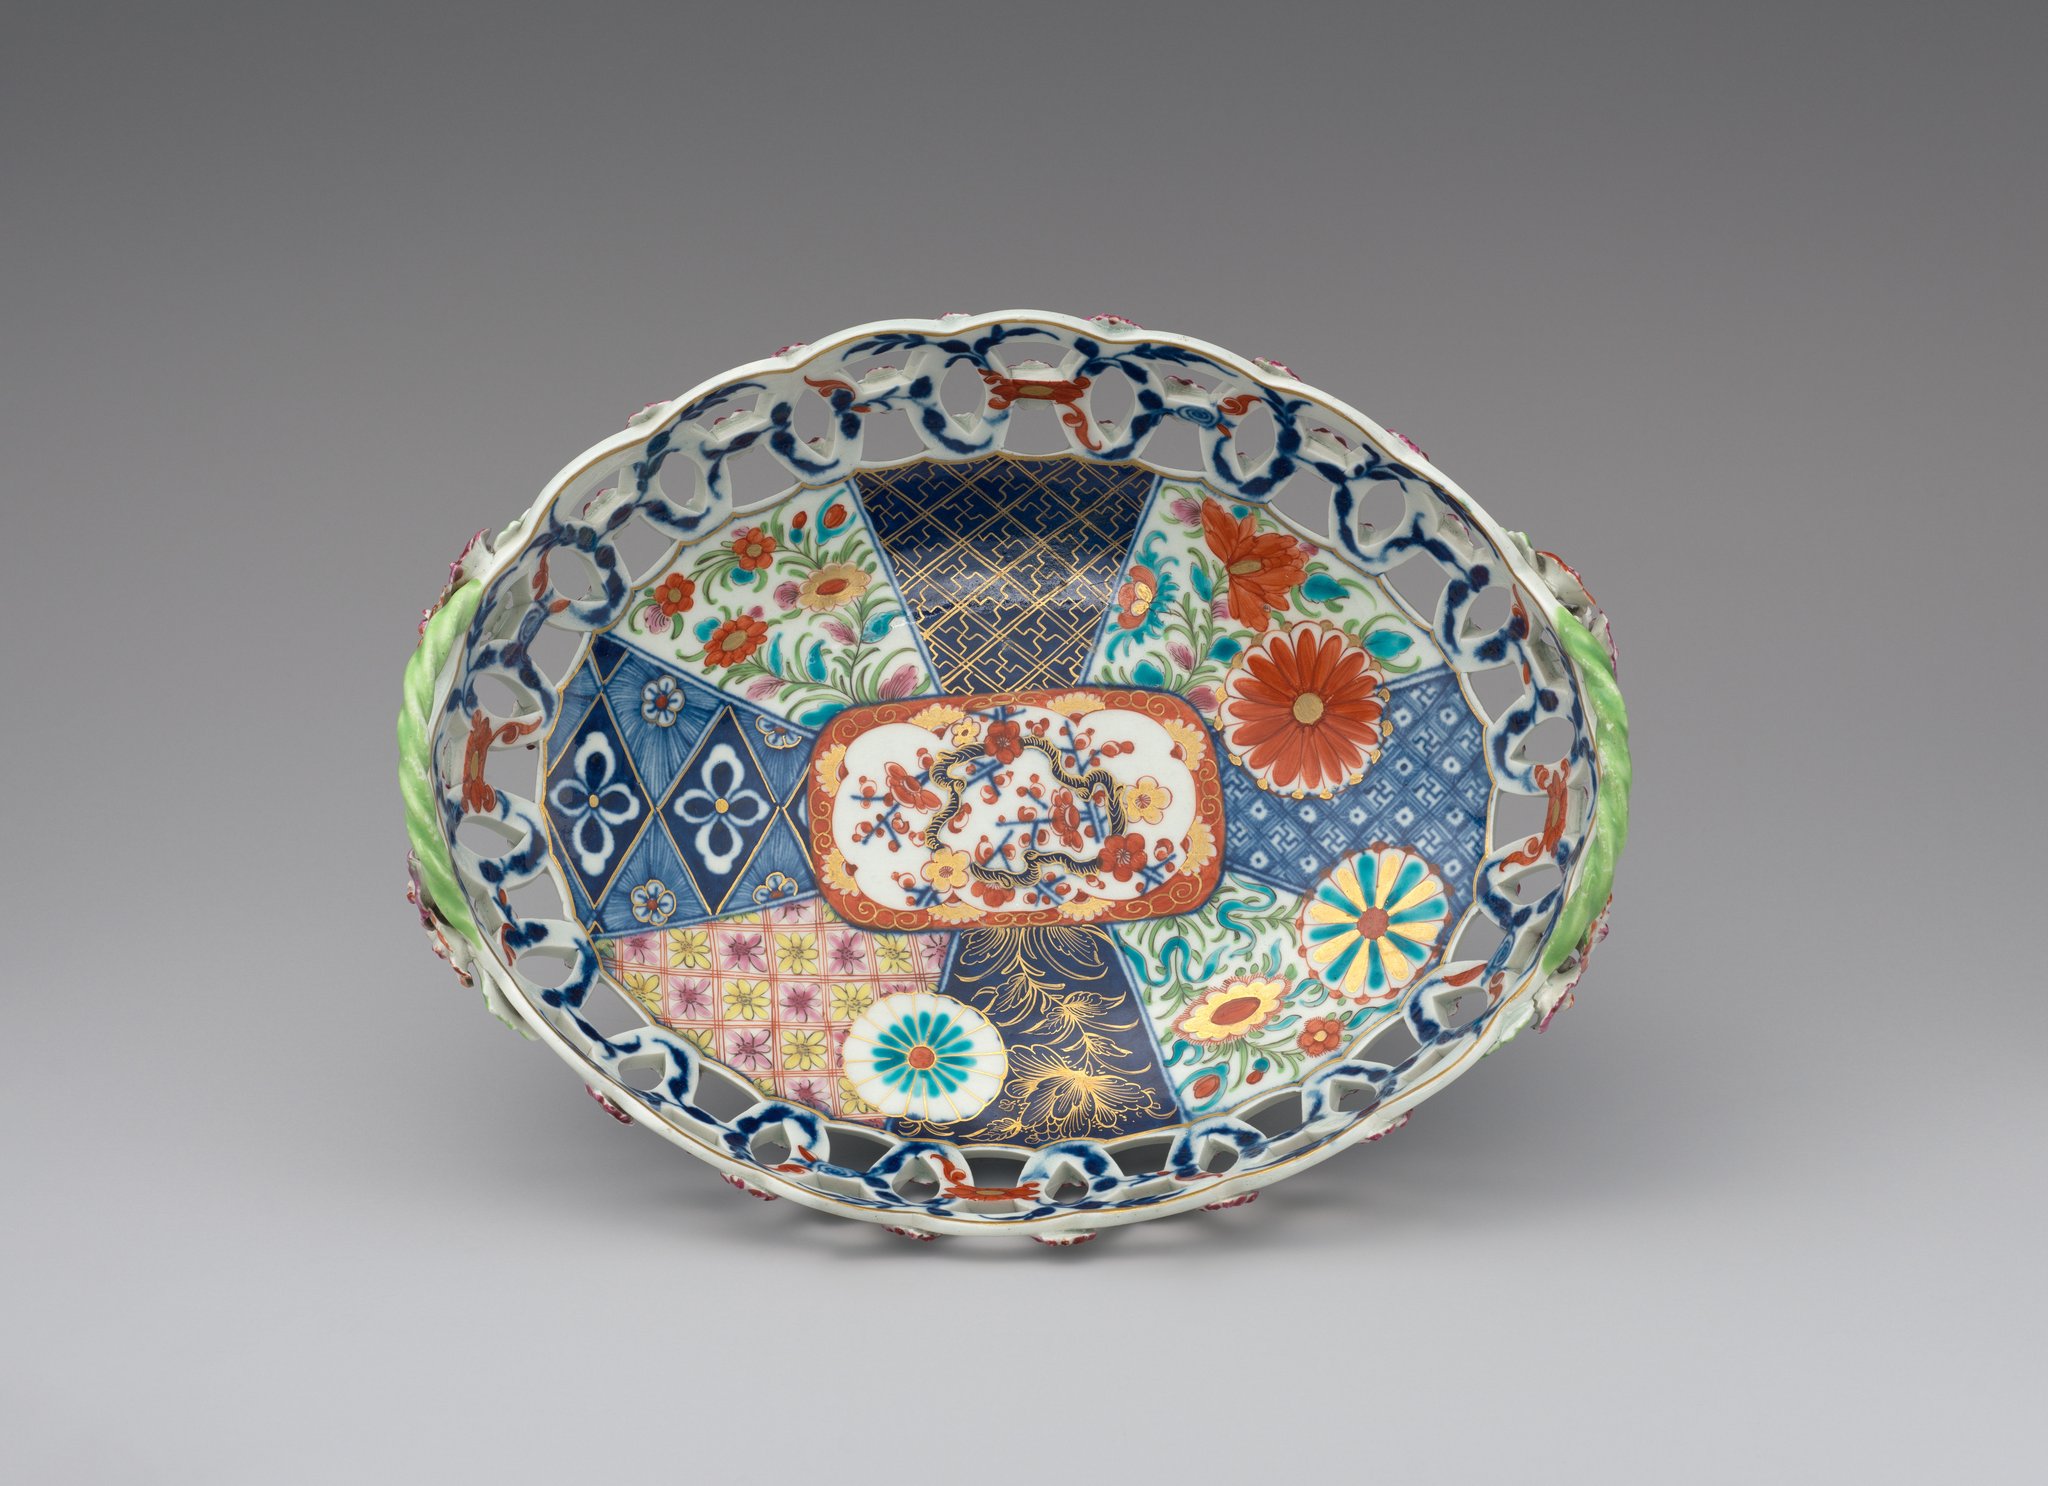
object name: dessert basket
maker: worcester factory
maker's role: factory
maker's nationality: british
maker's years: 1751-2008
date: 1765-1775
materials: soft paste porcelain